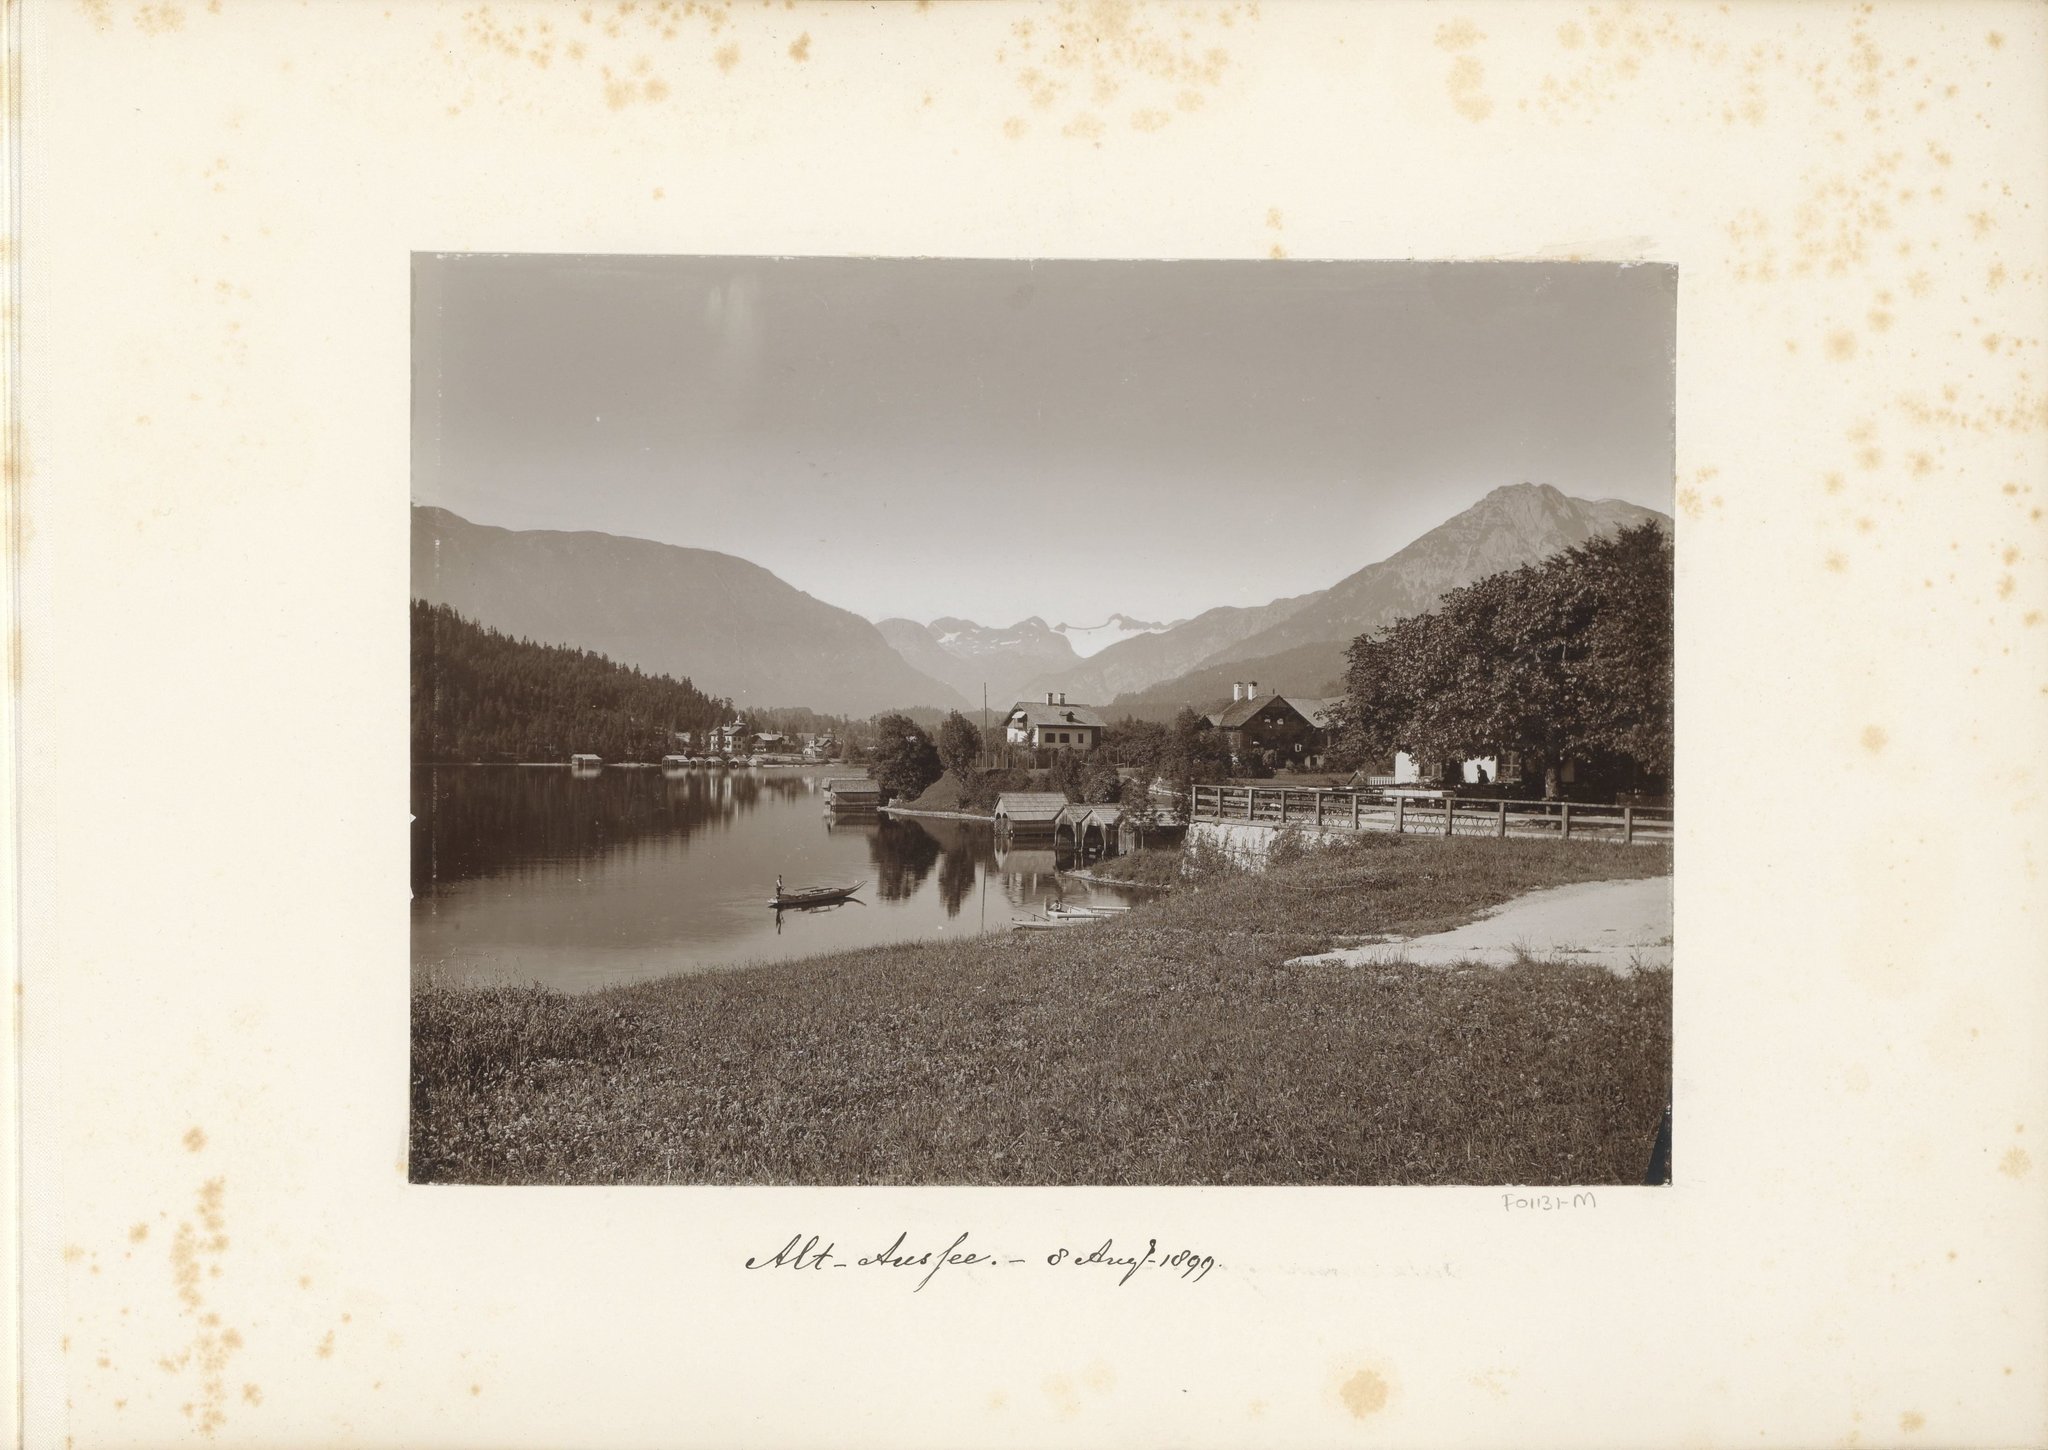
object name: photograph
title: Gezicht op de Altausseer See in het Salzkammergut met boten, huizen en omliggende bergen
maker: Anonymous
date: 1880-1899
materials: paper, photographic support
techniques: collodion silver print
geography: salzkammergut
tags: prospect of village, silhouette of village, rowing-boat, canoe, etc., lake, poling, punting, mountains (+ landscape with figures, staffage)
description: Onderdeel van Reisalbum met bezienswaardigheden in Duitsland, Oostenrijk, Zwitserland, Luxemburg en België.